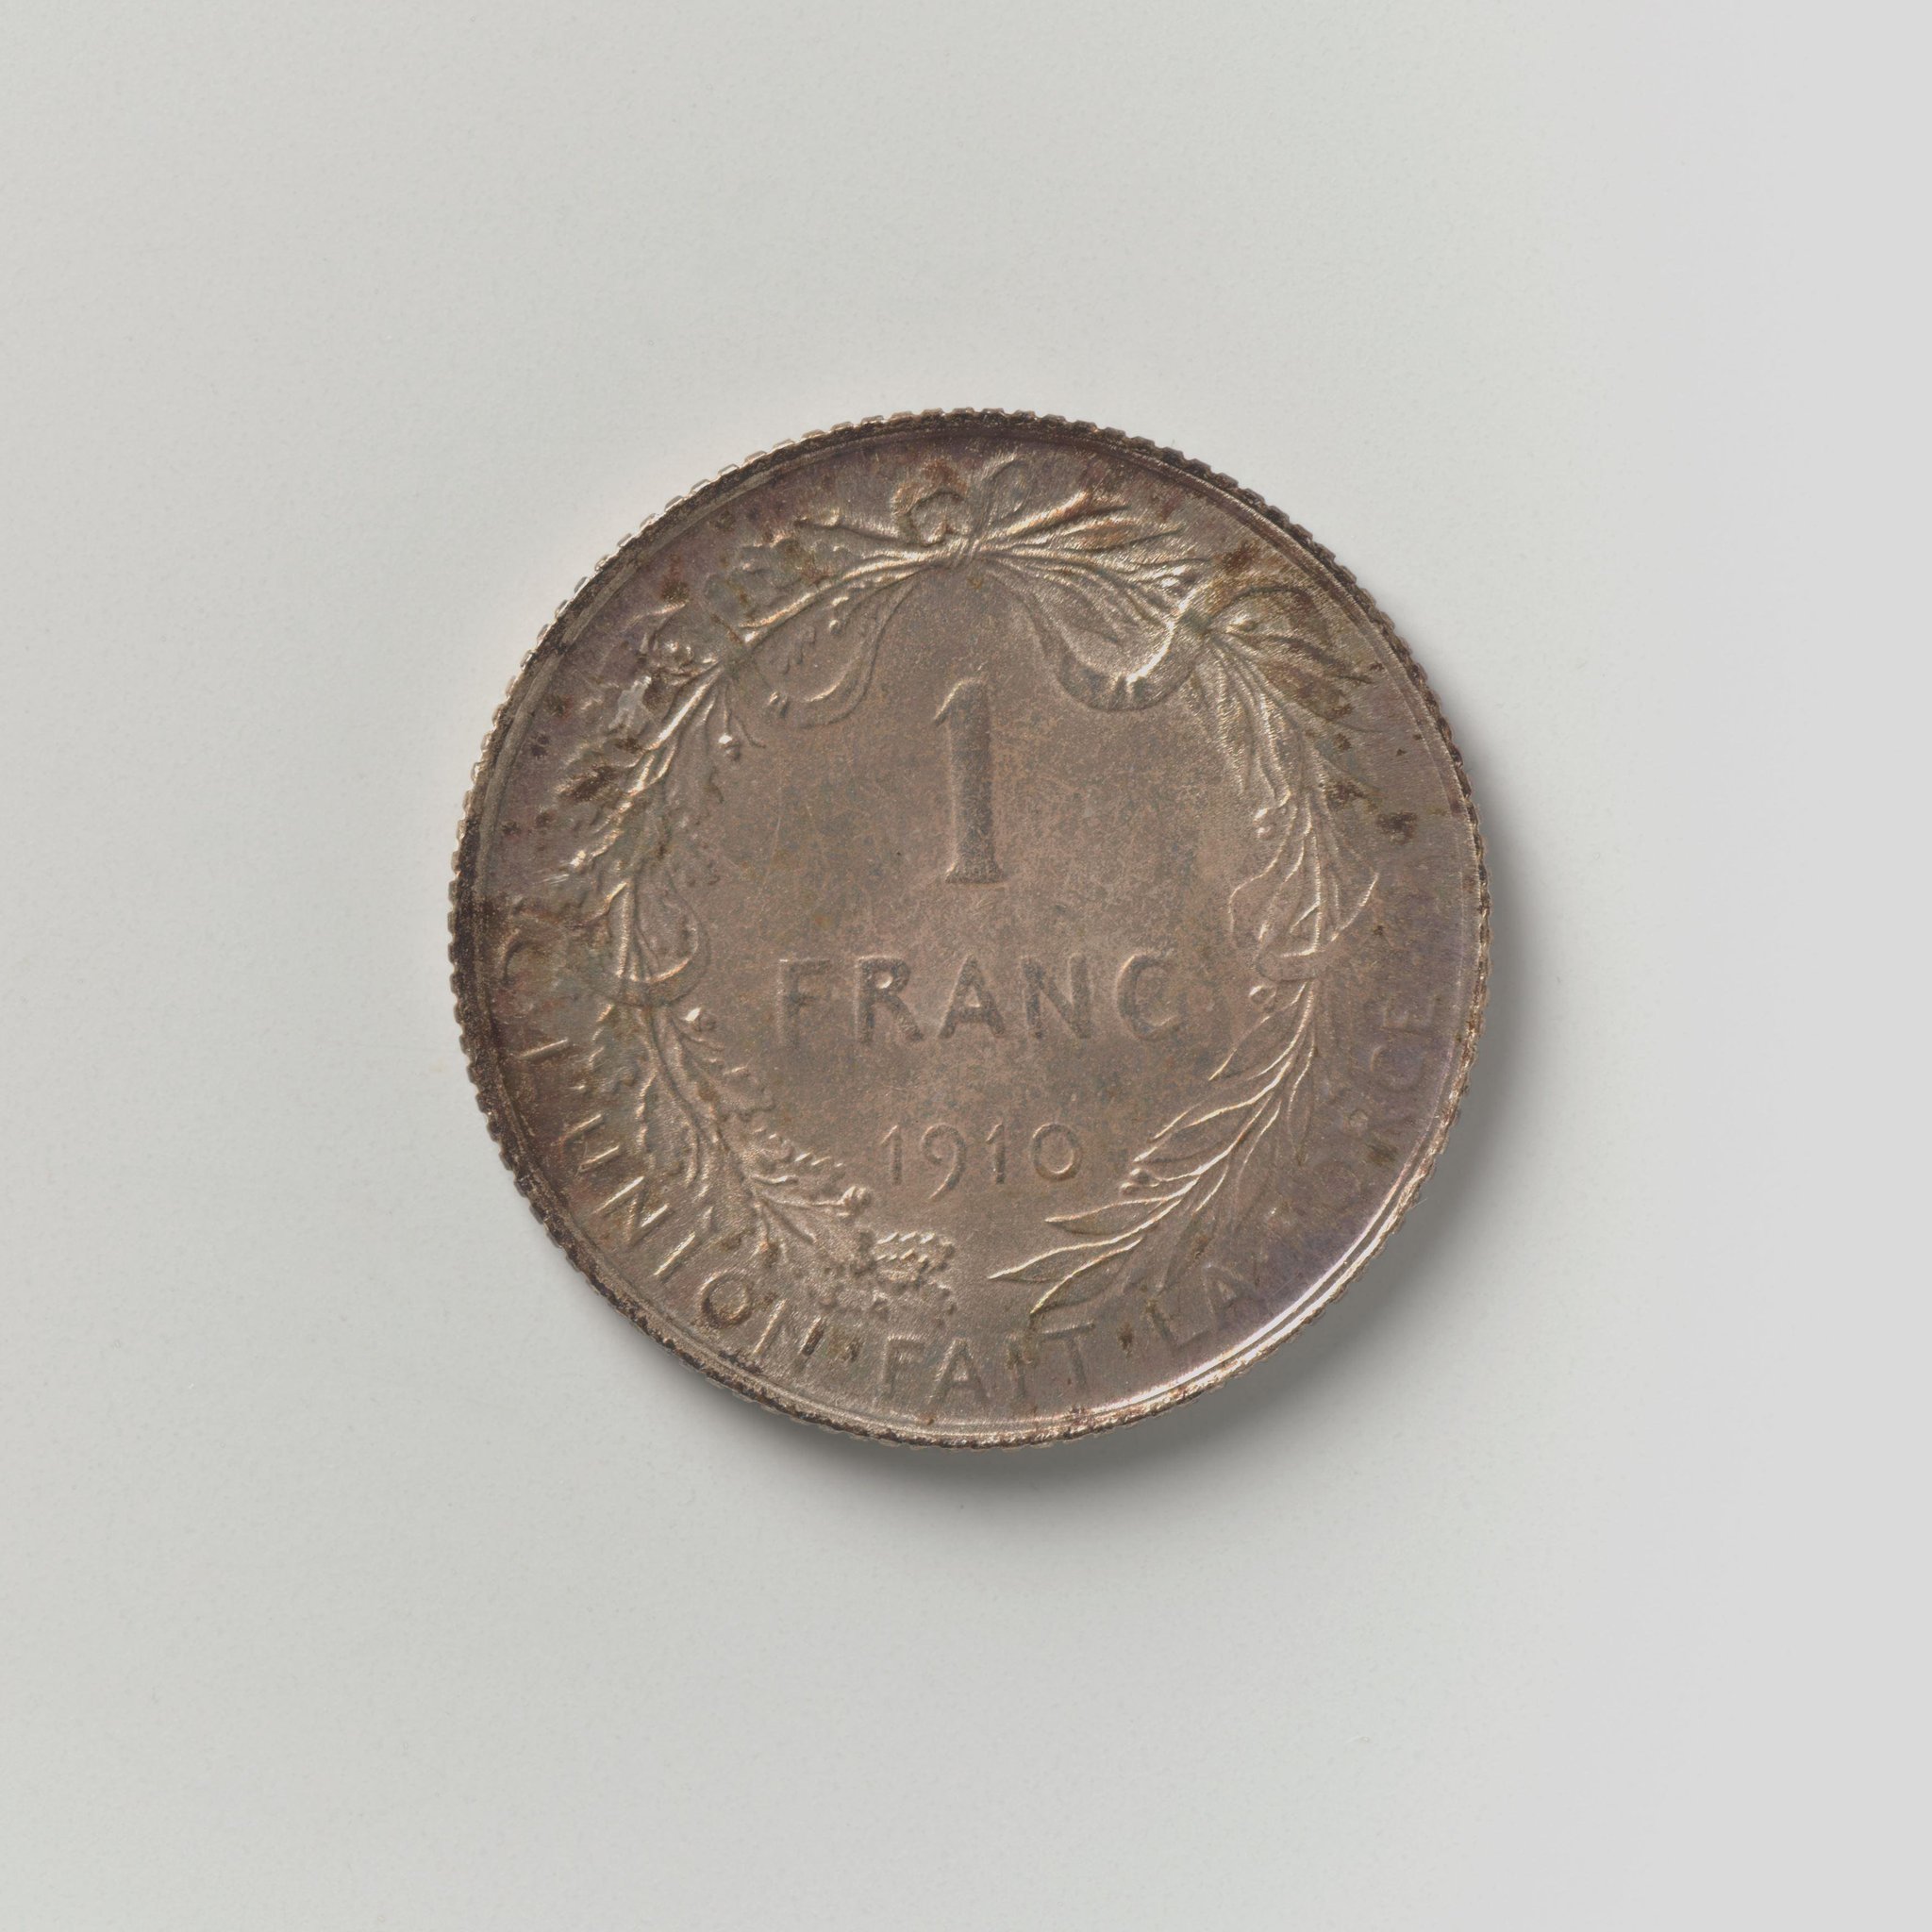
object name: coin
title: België, Albert I, franc, 1910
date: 1910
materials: silver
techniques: striking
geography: brussels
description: Zilveren munt. Voorzijde: portret van Albert I naar links. Keerzijde:tussen twee samengebonden takken waarde-aaanduiding in twee regels. Daaronder jaartal. Kartelrand.